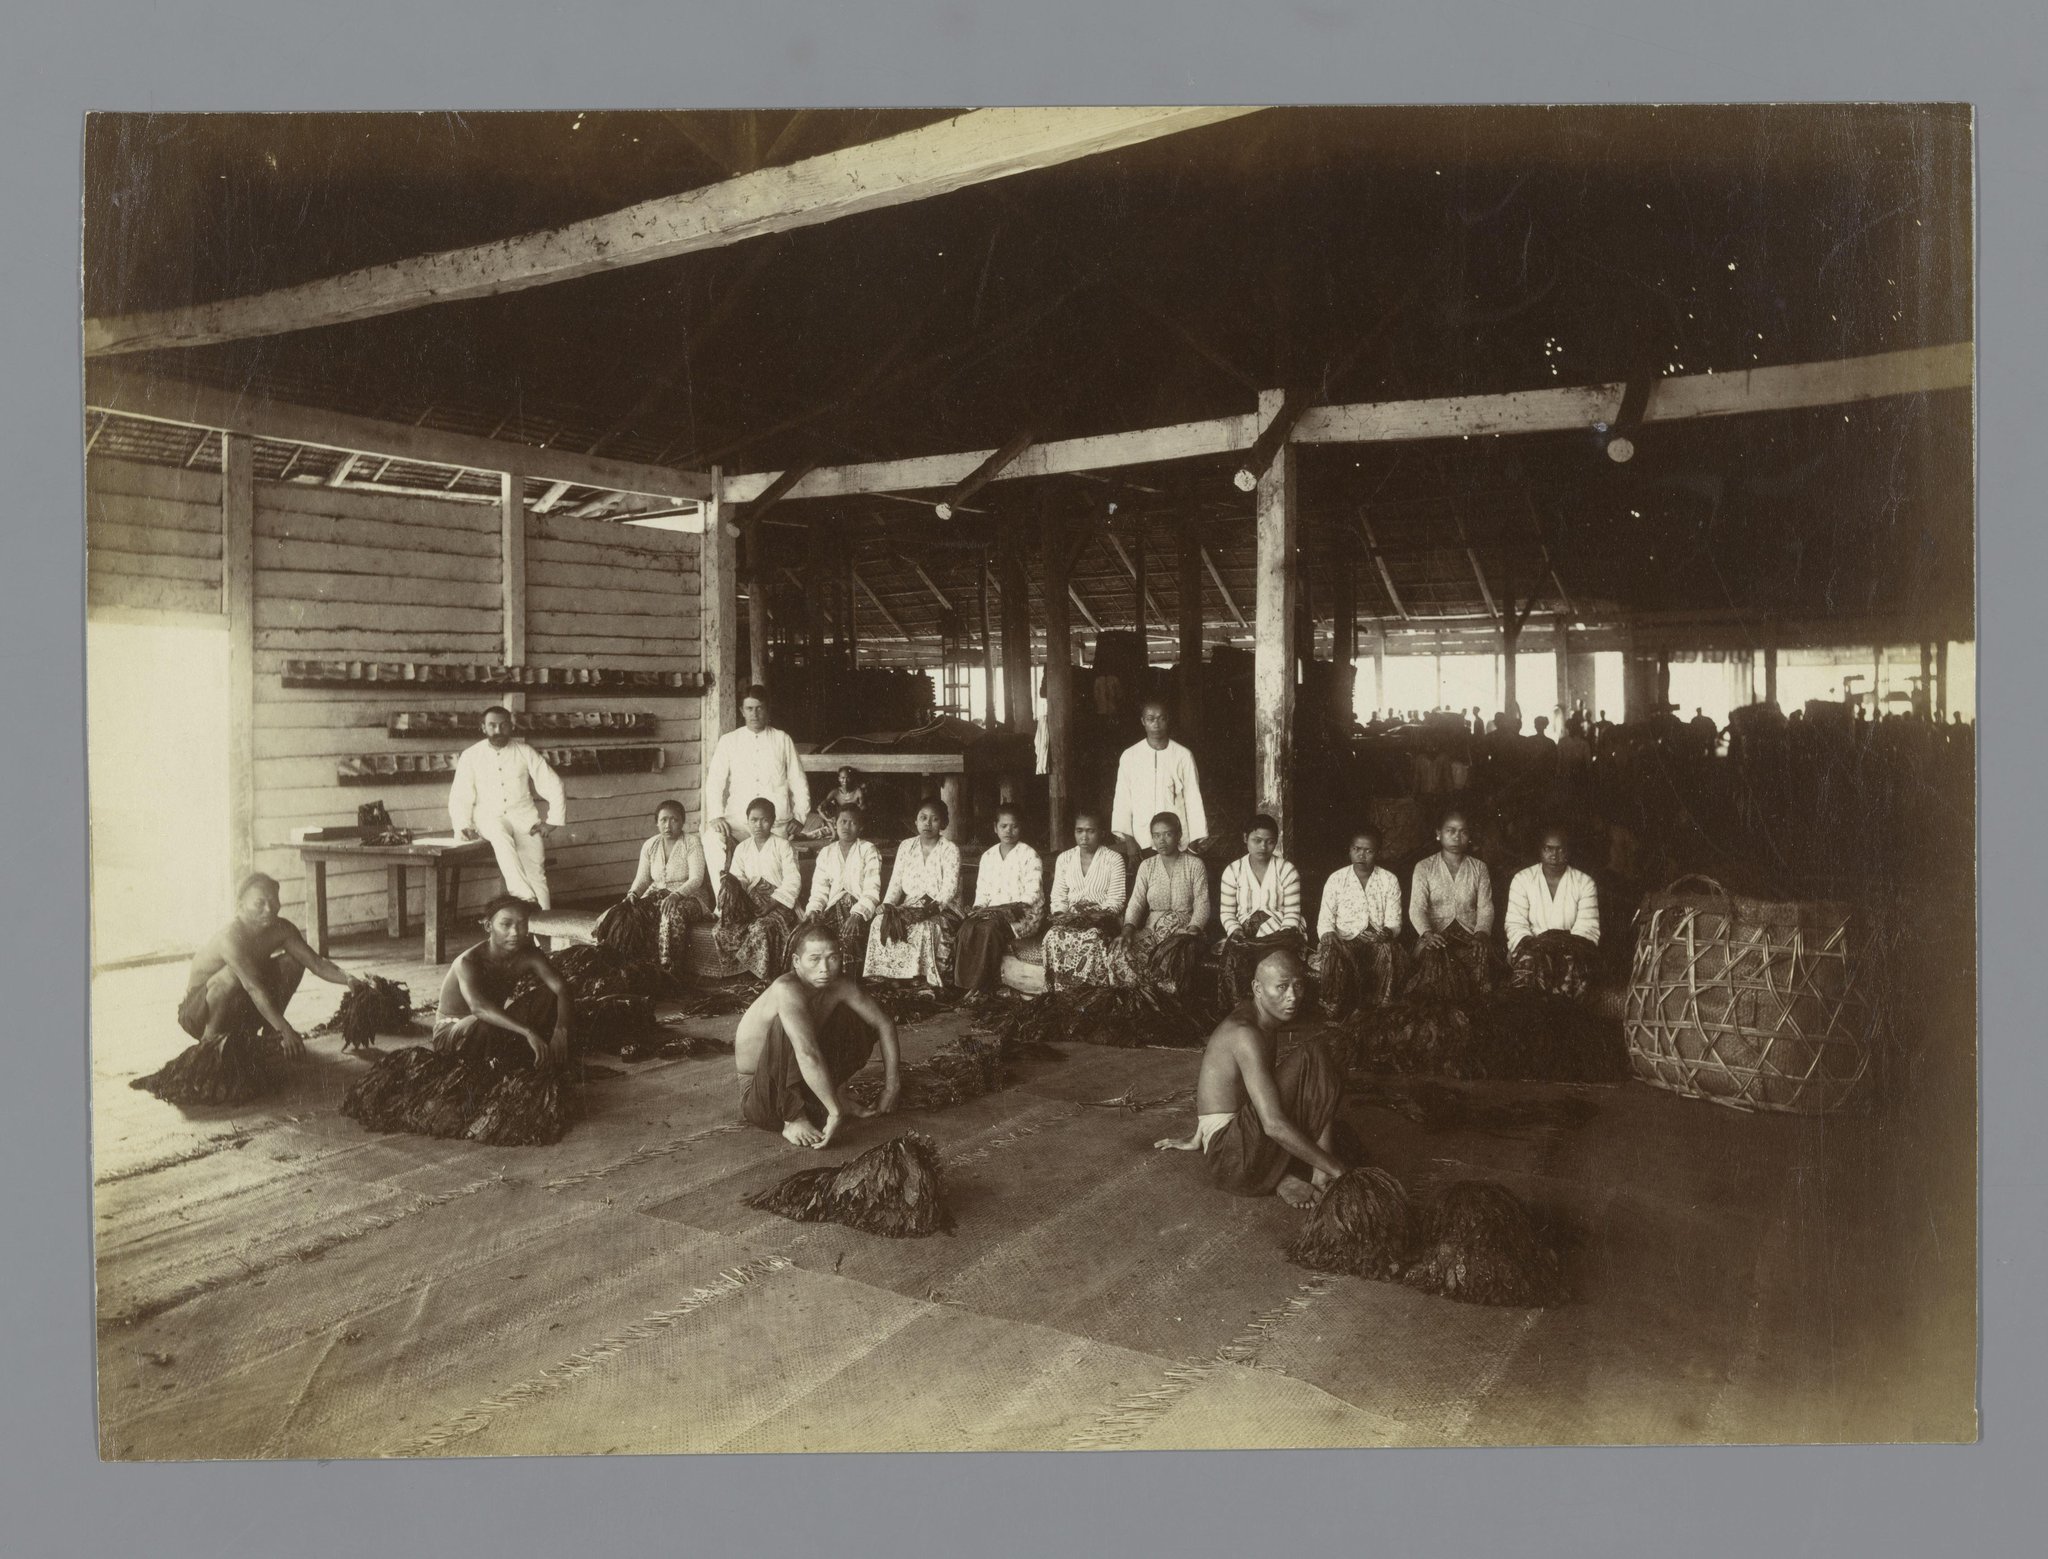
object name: photograph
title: Groepsportret van lokale contractarbeiders en twee Europese mannen in een droogschuur voor tabak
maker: Anonymous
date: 1880-1910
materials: paper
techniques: albumen print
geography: dutch east indies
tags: plantation, working class, labourers, tobacco, anonymous historical persons portrayed in a group, in a group-portrait, dutch east indies, the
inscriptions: inscription: ‘Kleingrothe (t)’